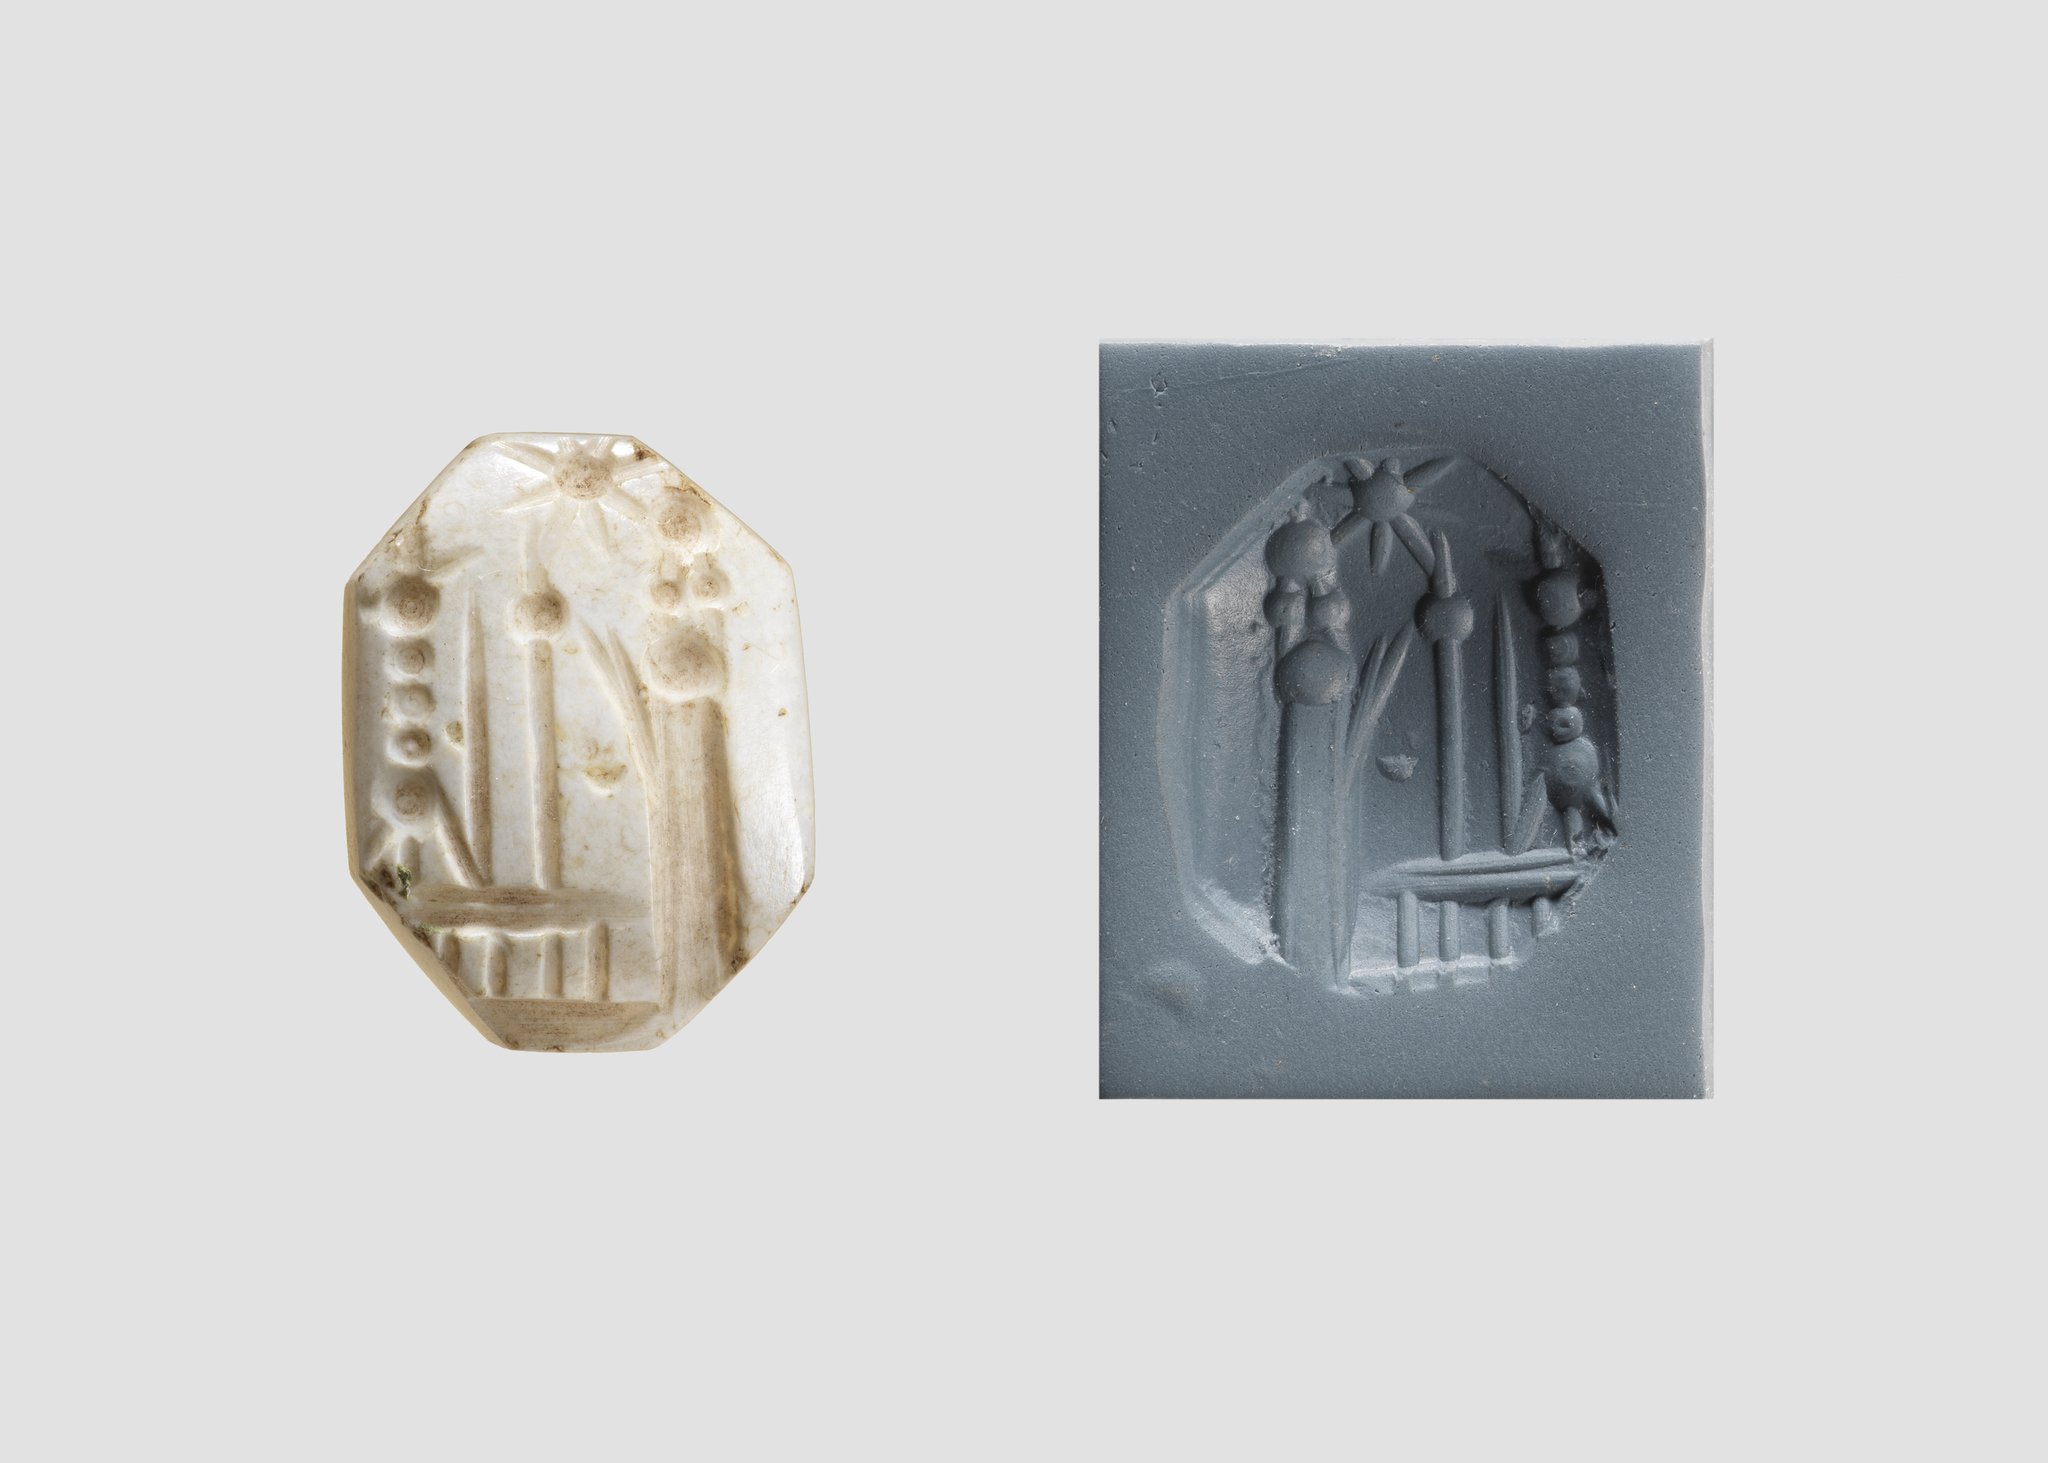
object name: stamp seal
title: Stamp seal (octagonal pyramid) with cultic scene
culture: assyro-babylonian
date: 700-501 BCE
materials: stone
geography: mesopotamia